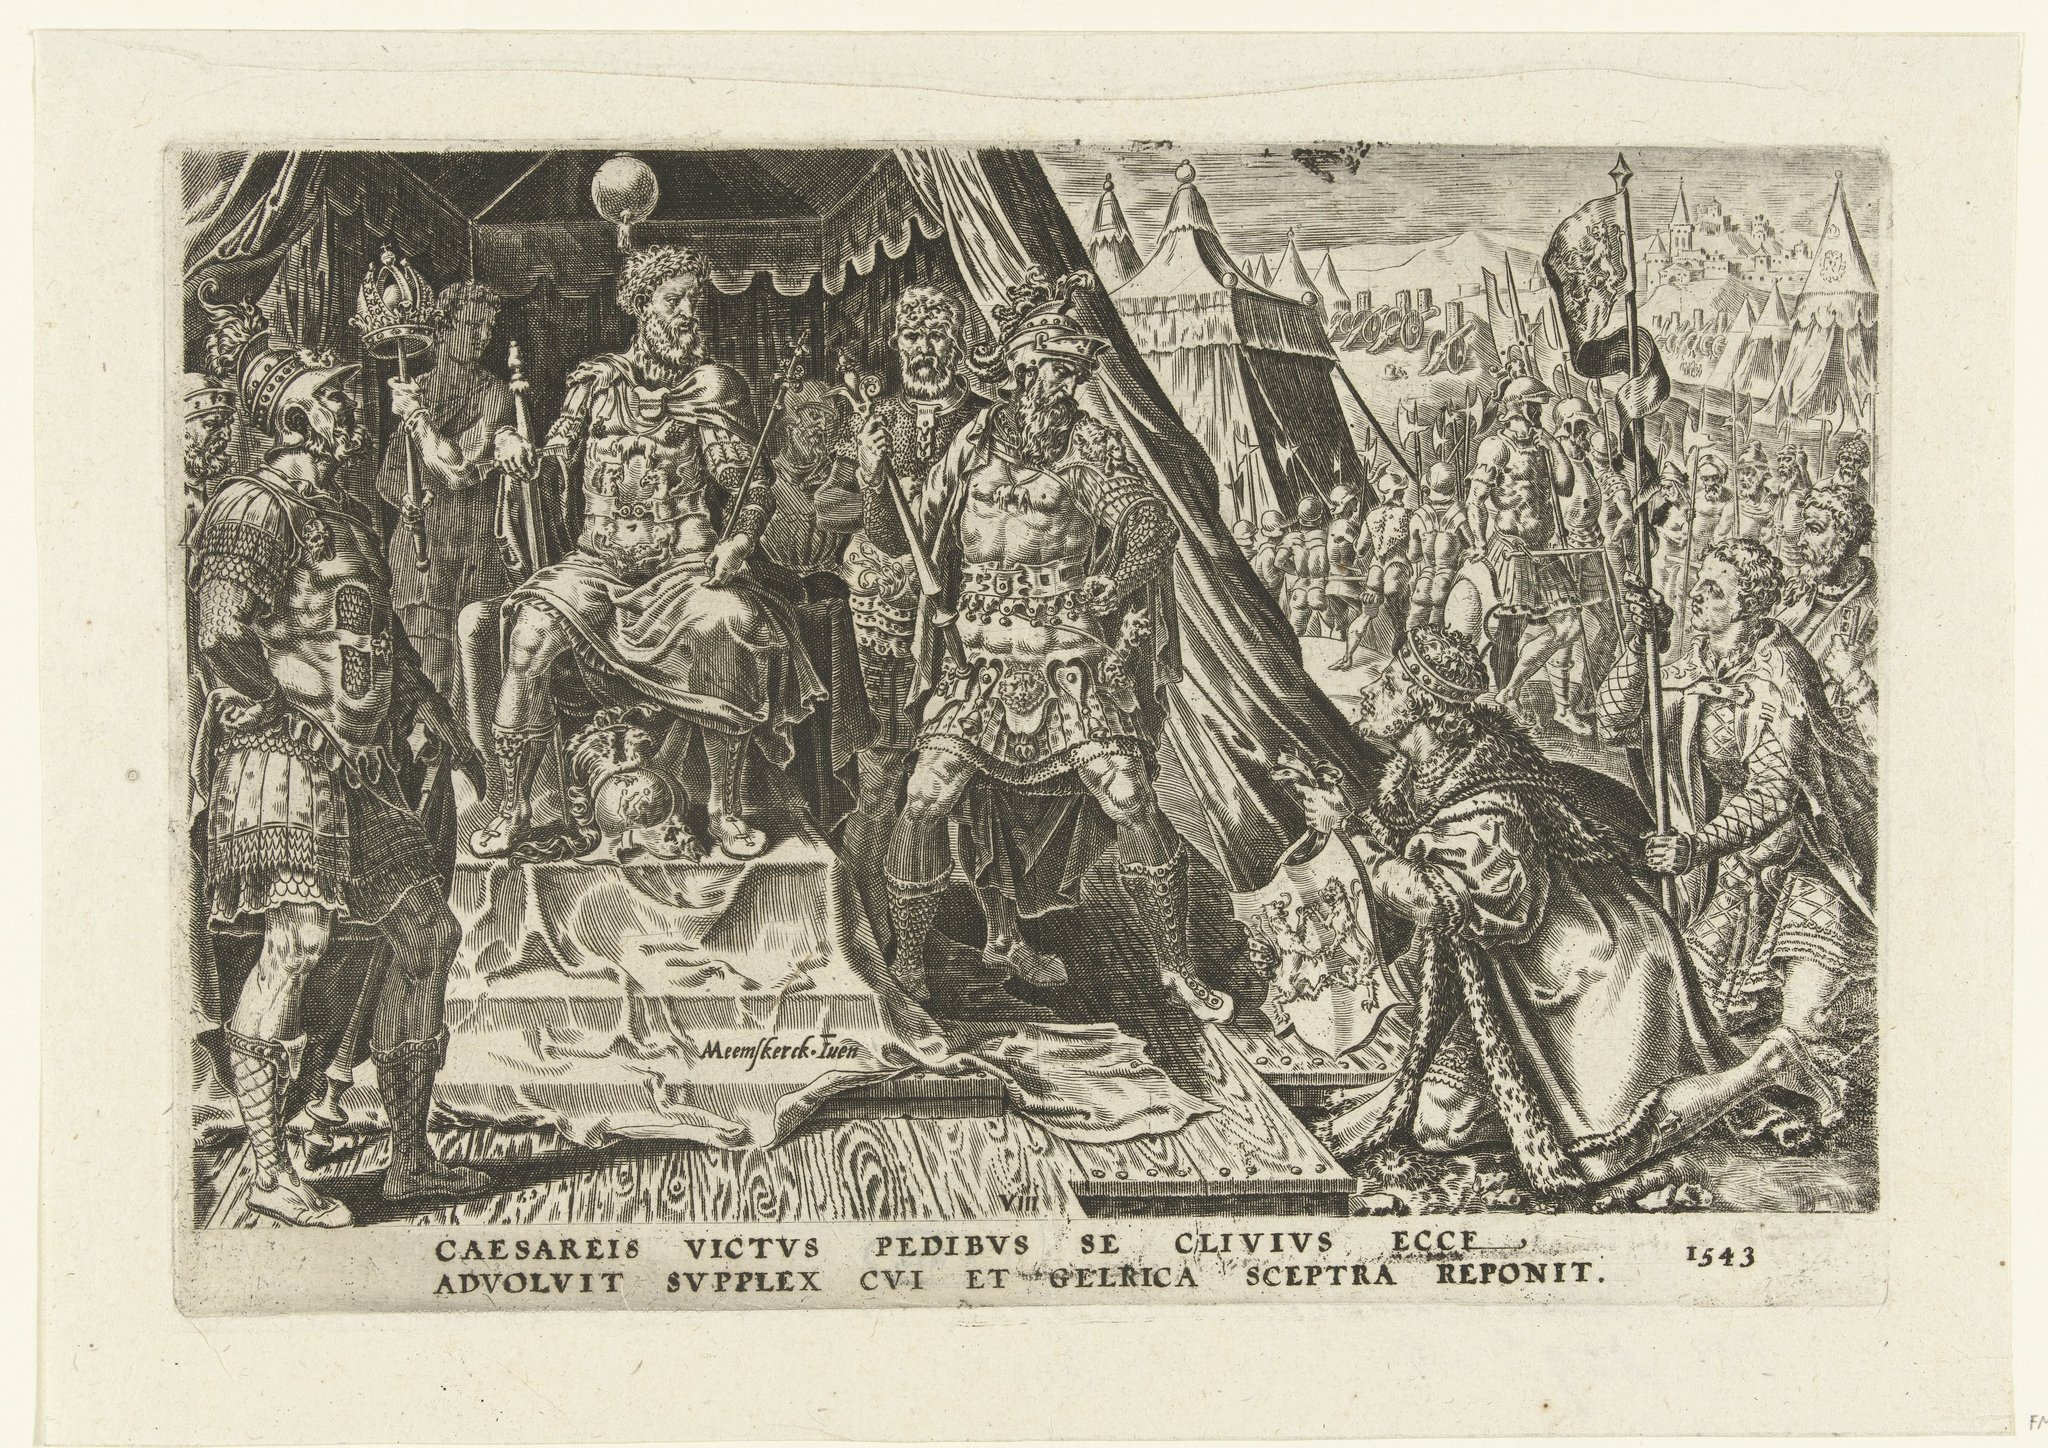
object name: history print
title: Overwinningen van Karel V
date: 1555-1556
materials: paper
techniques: engraving, etching, letterpress printing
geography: antwerp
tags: charles v (holy roman emperor and king of spain)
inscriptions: collector's mark: Lugt 2228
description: Tijdens de Vrede van Venlo (1543) knielt de hertog van Gelre, Willem II, voor de troon van keizer Karel V en onderwerpt zich aan zijn macht. Hij overhandigt hem het wapenschild van Gelre. De prent maakt deel uit van een twaalfdelige serie over de overwinningen van Karel V.